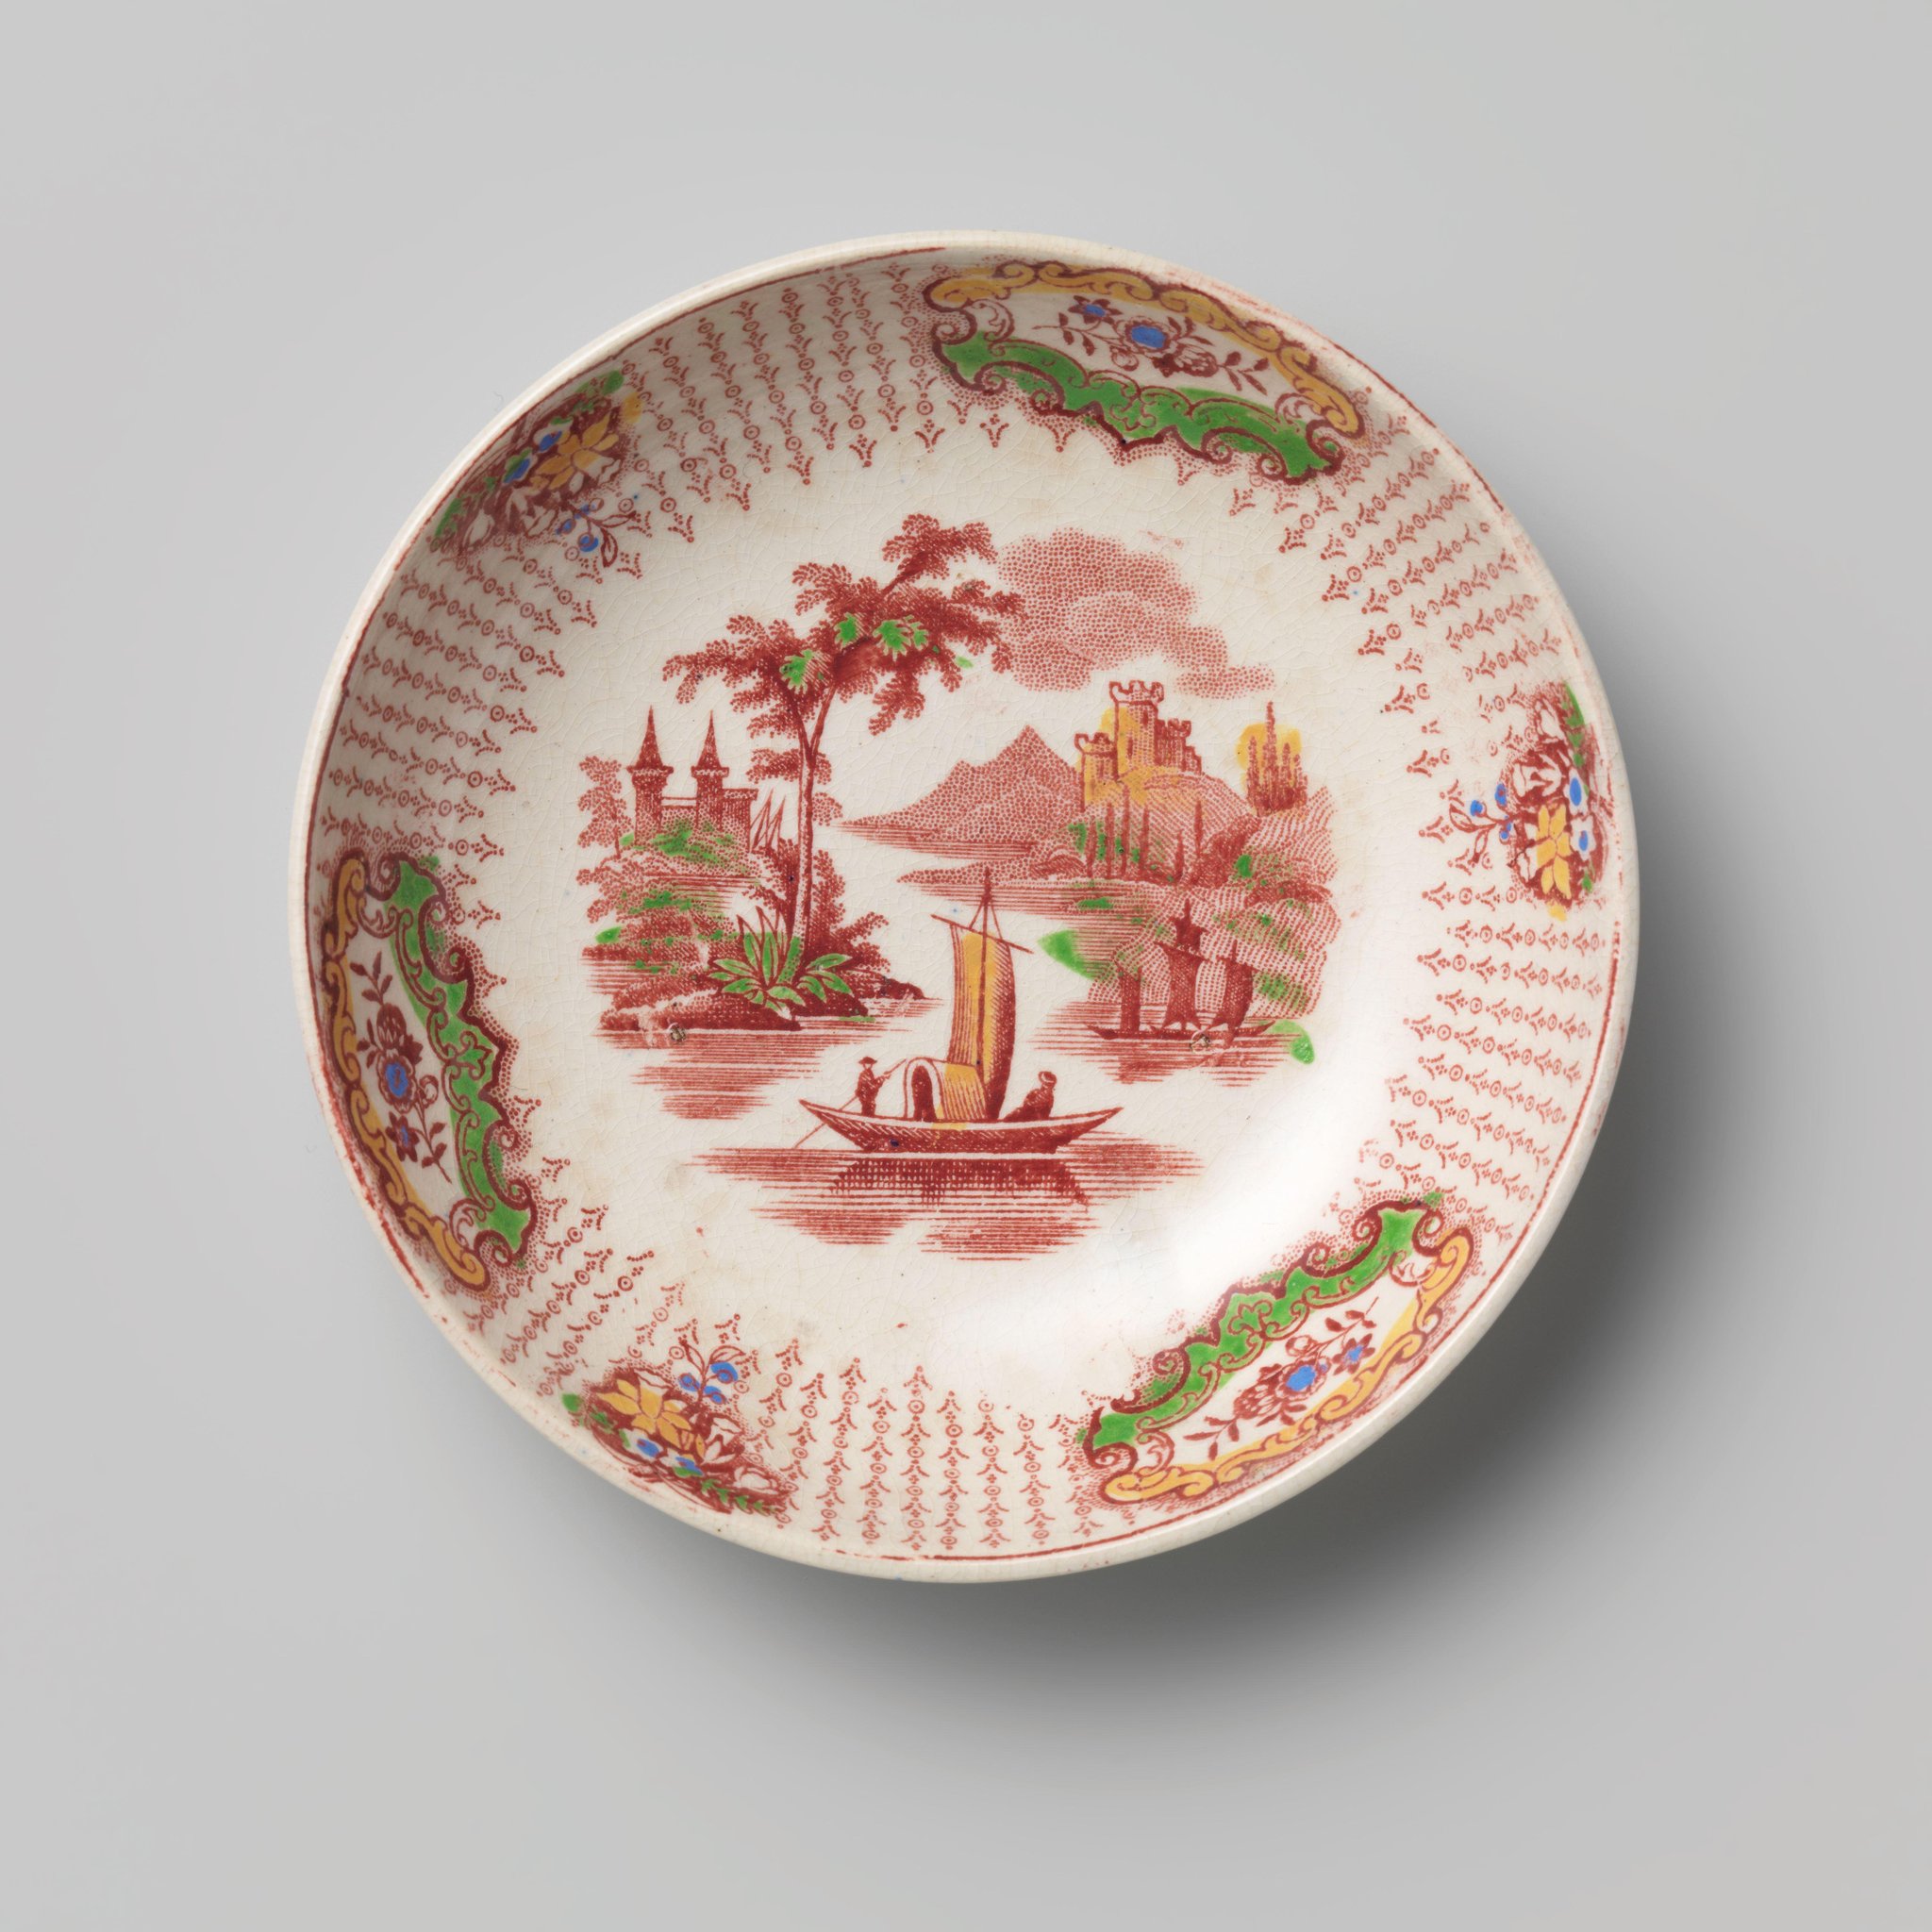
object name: platter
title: Schotel van hardgebakken aardewerk, fijn creamware met transfer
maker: Anonymous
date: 1830-1850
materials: earthenware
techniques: transfer decoration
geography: england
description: Ronde schotel van hardgebakken aardewerk met veelkleurige transfer. Het plat heeft een afbeelding van een rivierlandschap met een boot. De rand heeft drie medaillons waarin bloemtakken en drie boeketten tussen een fond van gestileerde verticale takken. De schotel hoort bij een kop en bij drie gelijke koppen met schotels (BK-14818-A-1 t/m BK-14818-D-2).